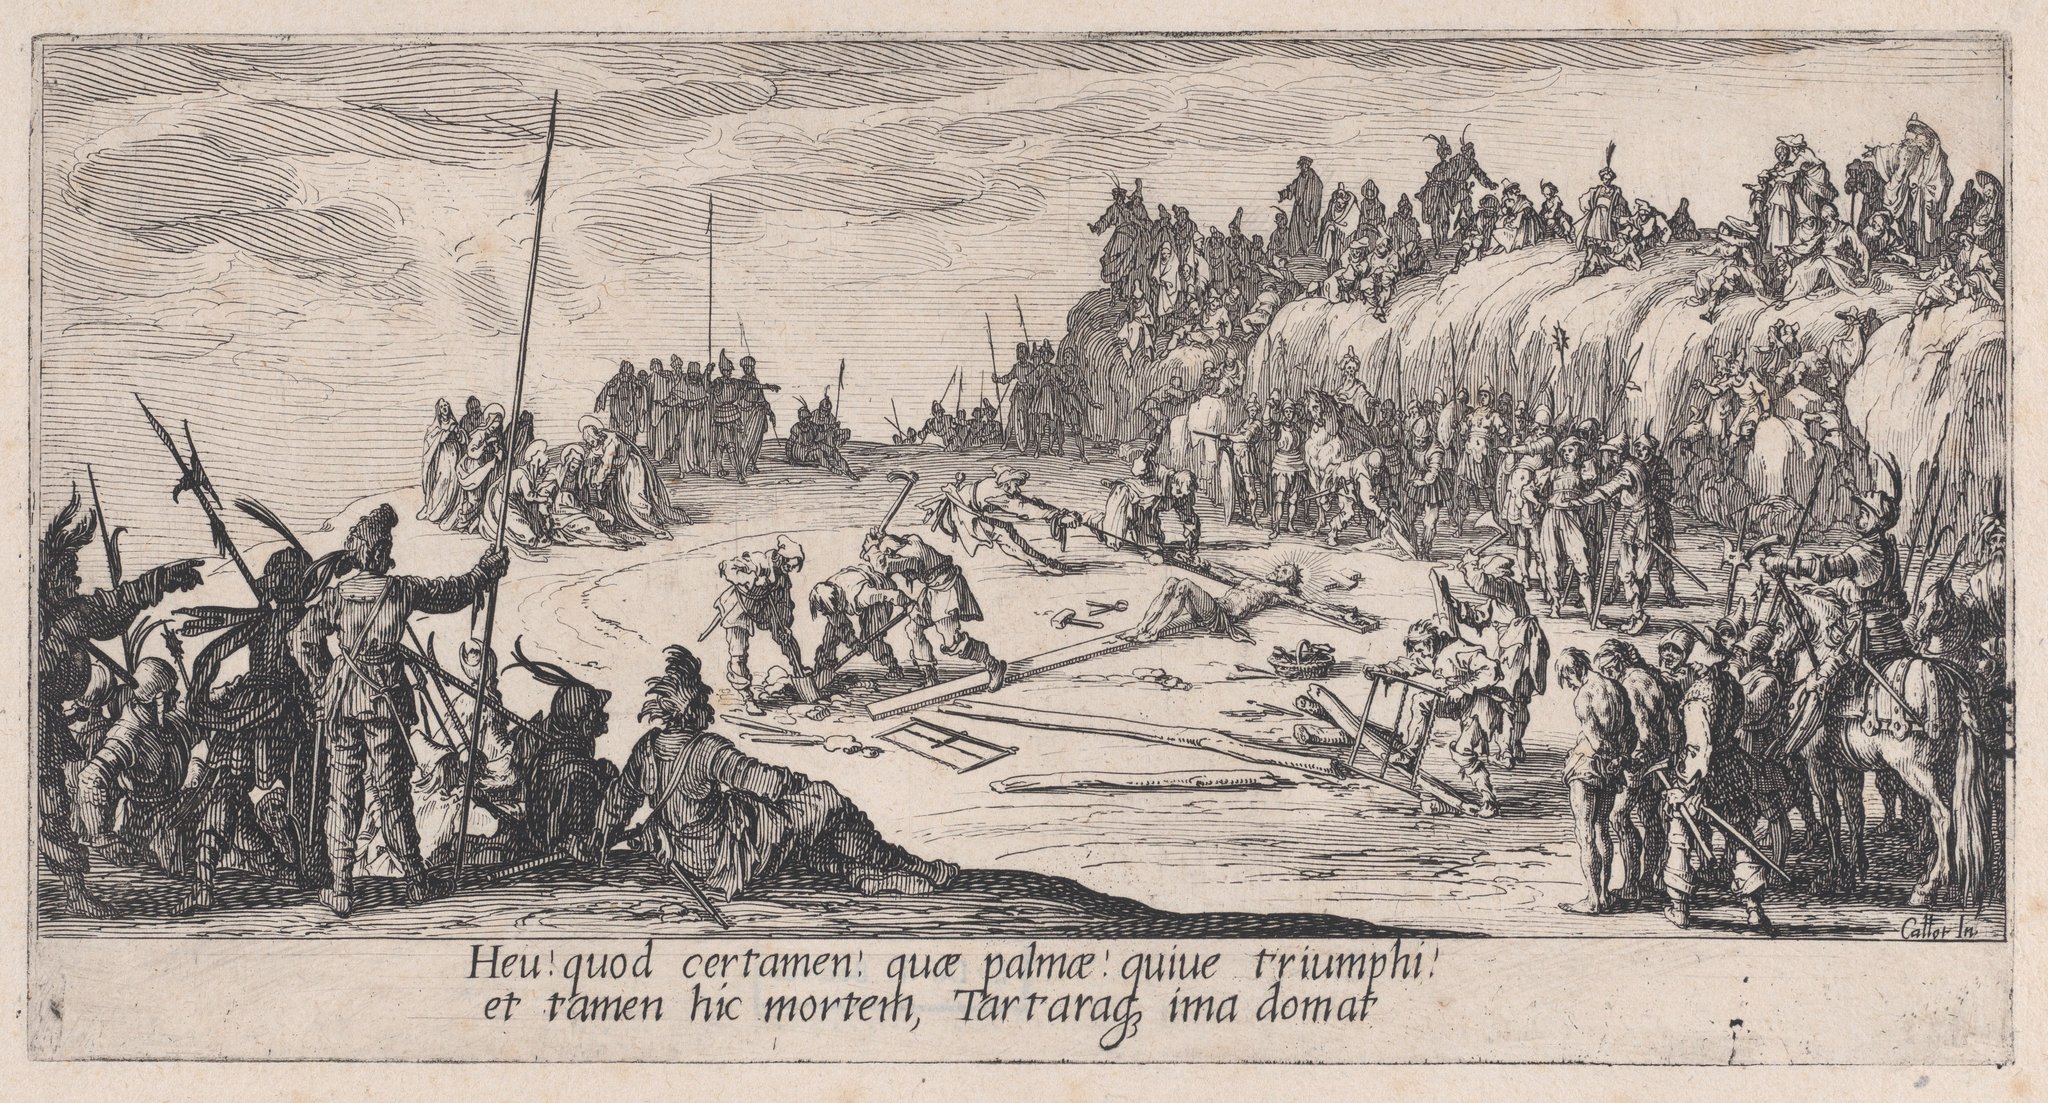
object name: print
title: Le Crucifiement (The Crucifixion), from "La Grande Passion" (The Large Passion)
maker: jacques callot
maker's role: artist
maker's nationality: french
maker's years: 1592-1635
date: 1619-1624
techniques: engraving, etching